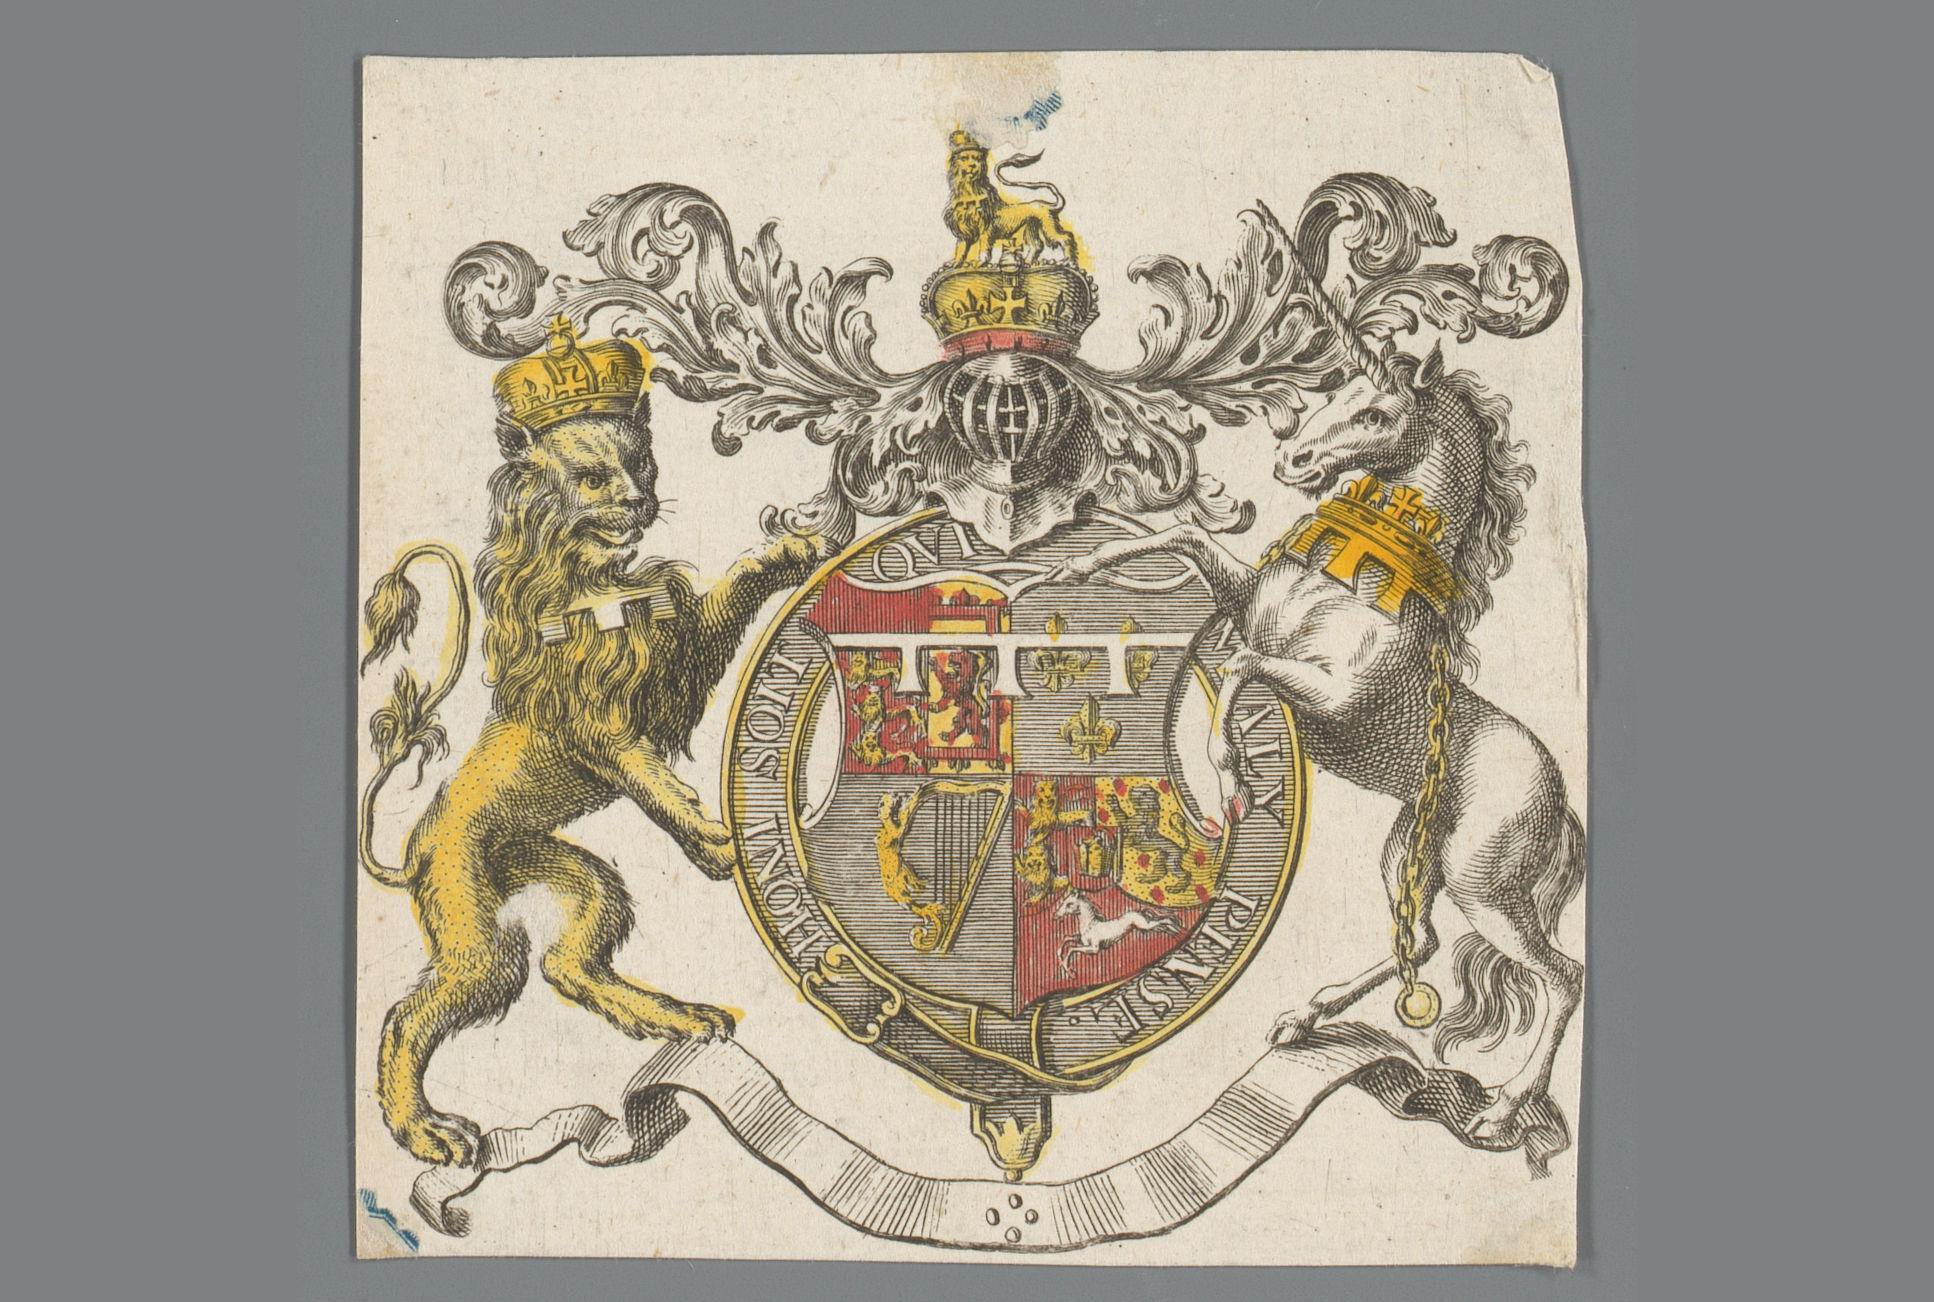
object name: book illustration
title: Wappen des Printzens von Wallis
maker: Anonymous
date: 1746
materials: paper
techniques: engraving, hand coloring, letterpress printing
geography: nuremberg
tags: unicorn, beasts of prey, predatory animals: lion (+ heraldic animals), armorial bearing, heraldry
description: Prent uit: Der durchlauchtigen Welt (...) Geschichts-Geschlechts- und Wappen-Kalender (...). Neurenberg: erven Christoph Weigel, 1746.